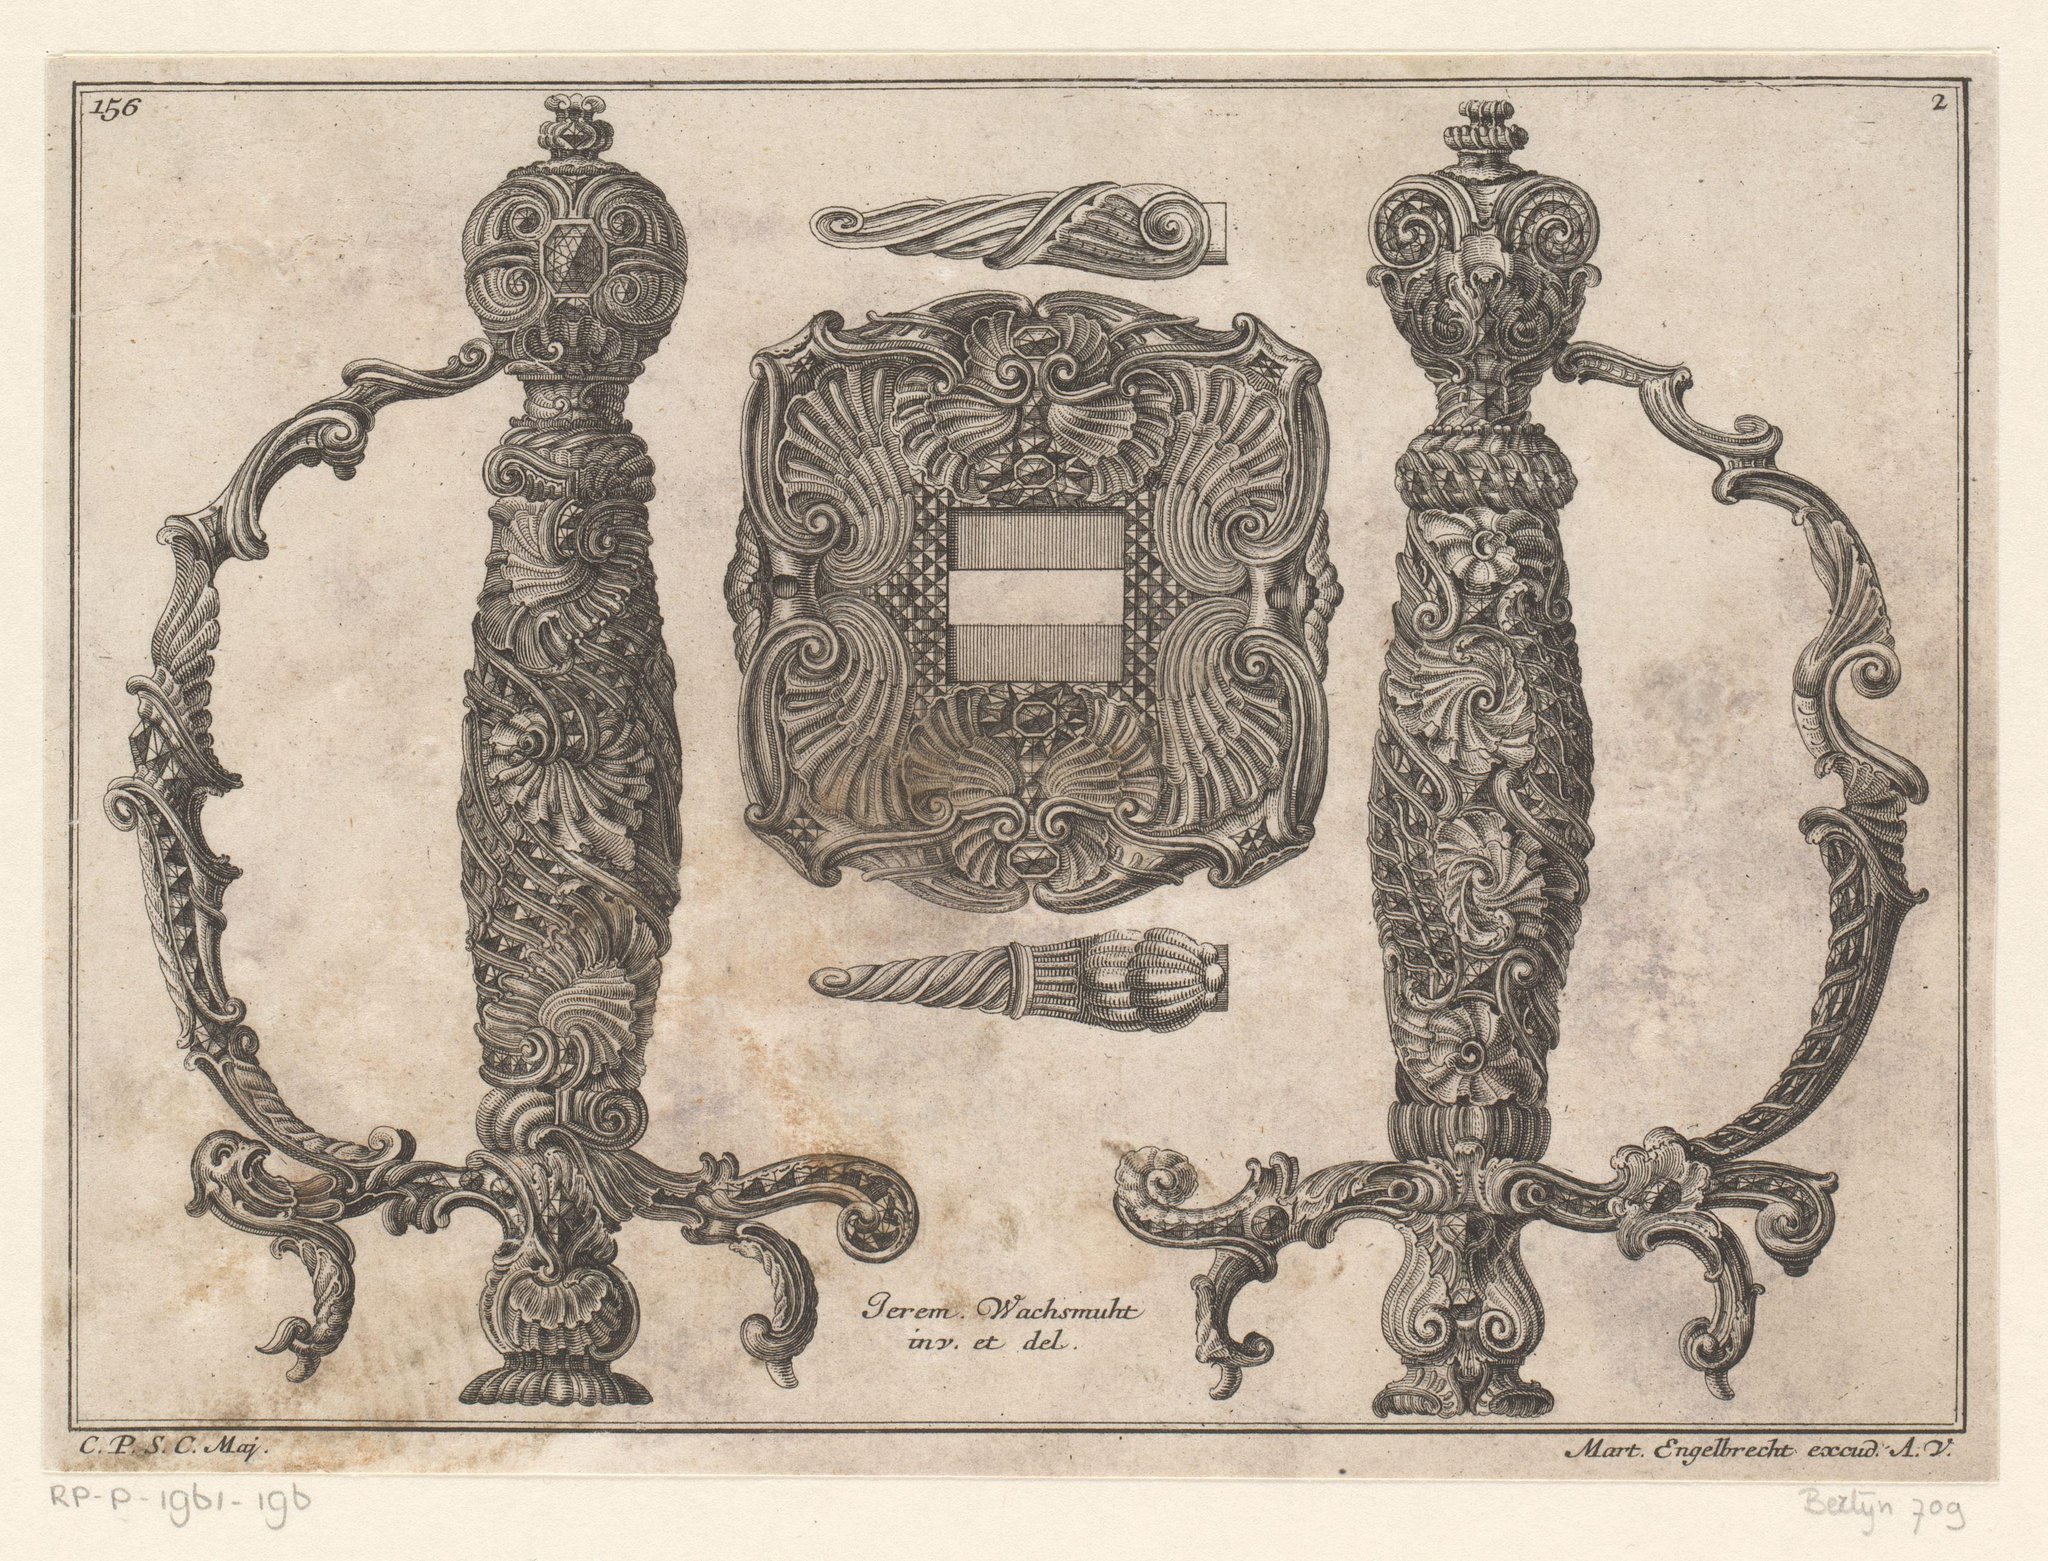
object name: print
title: Degengevesten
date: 1721-1756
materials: paper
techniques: etching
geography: augsburg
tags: parts of hacking and thrusting weapons: grip, hacking and thrusting weapons: rapier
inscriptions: collector's mark: Lugt 2228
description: Twee geornamenteerde degengevesten met links onder een vogelkop. Prentnummer 156.